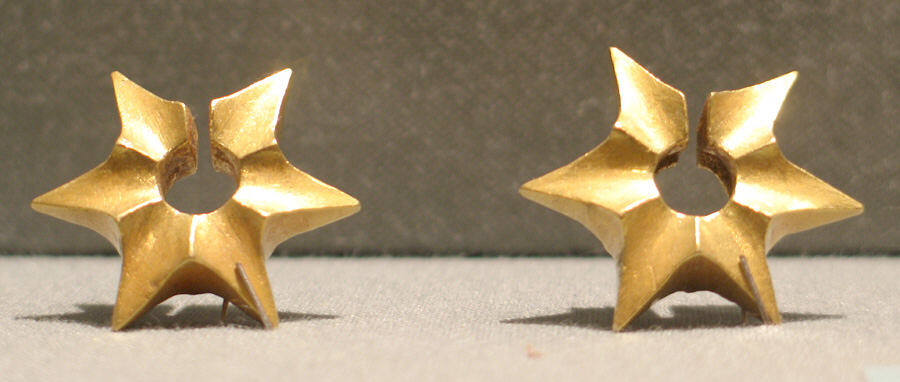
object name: ear clip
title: Pair of Ear Clips in the Shape of a Starfruit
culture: indonesian, javanese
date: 701-933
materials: gold